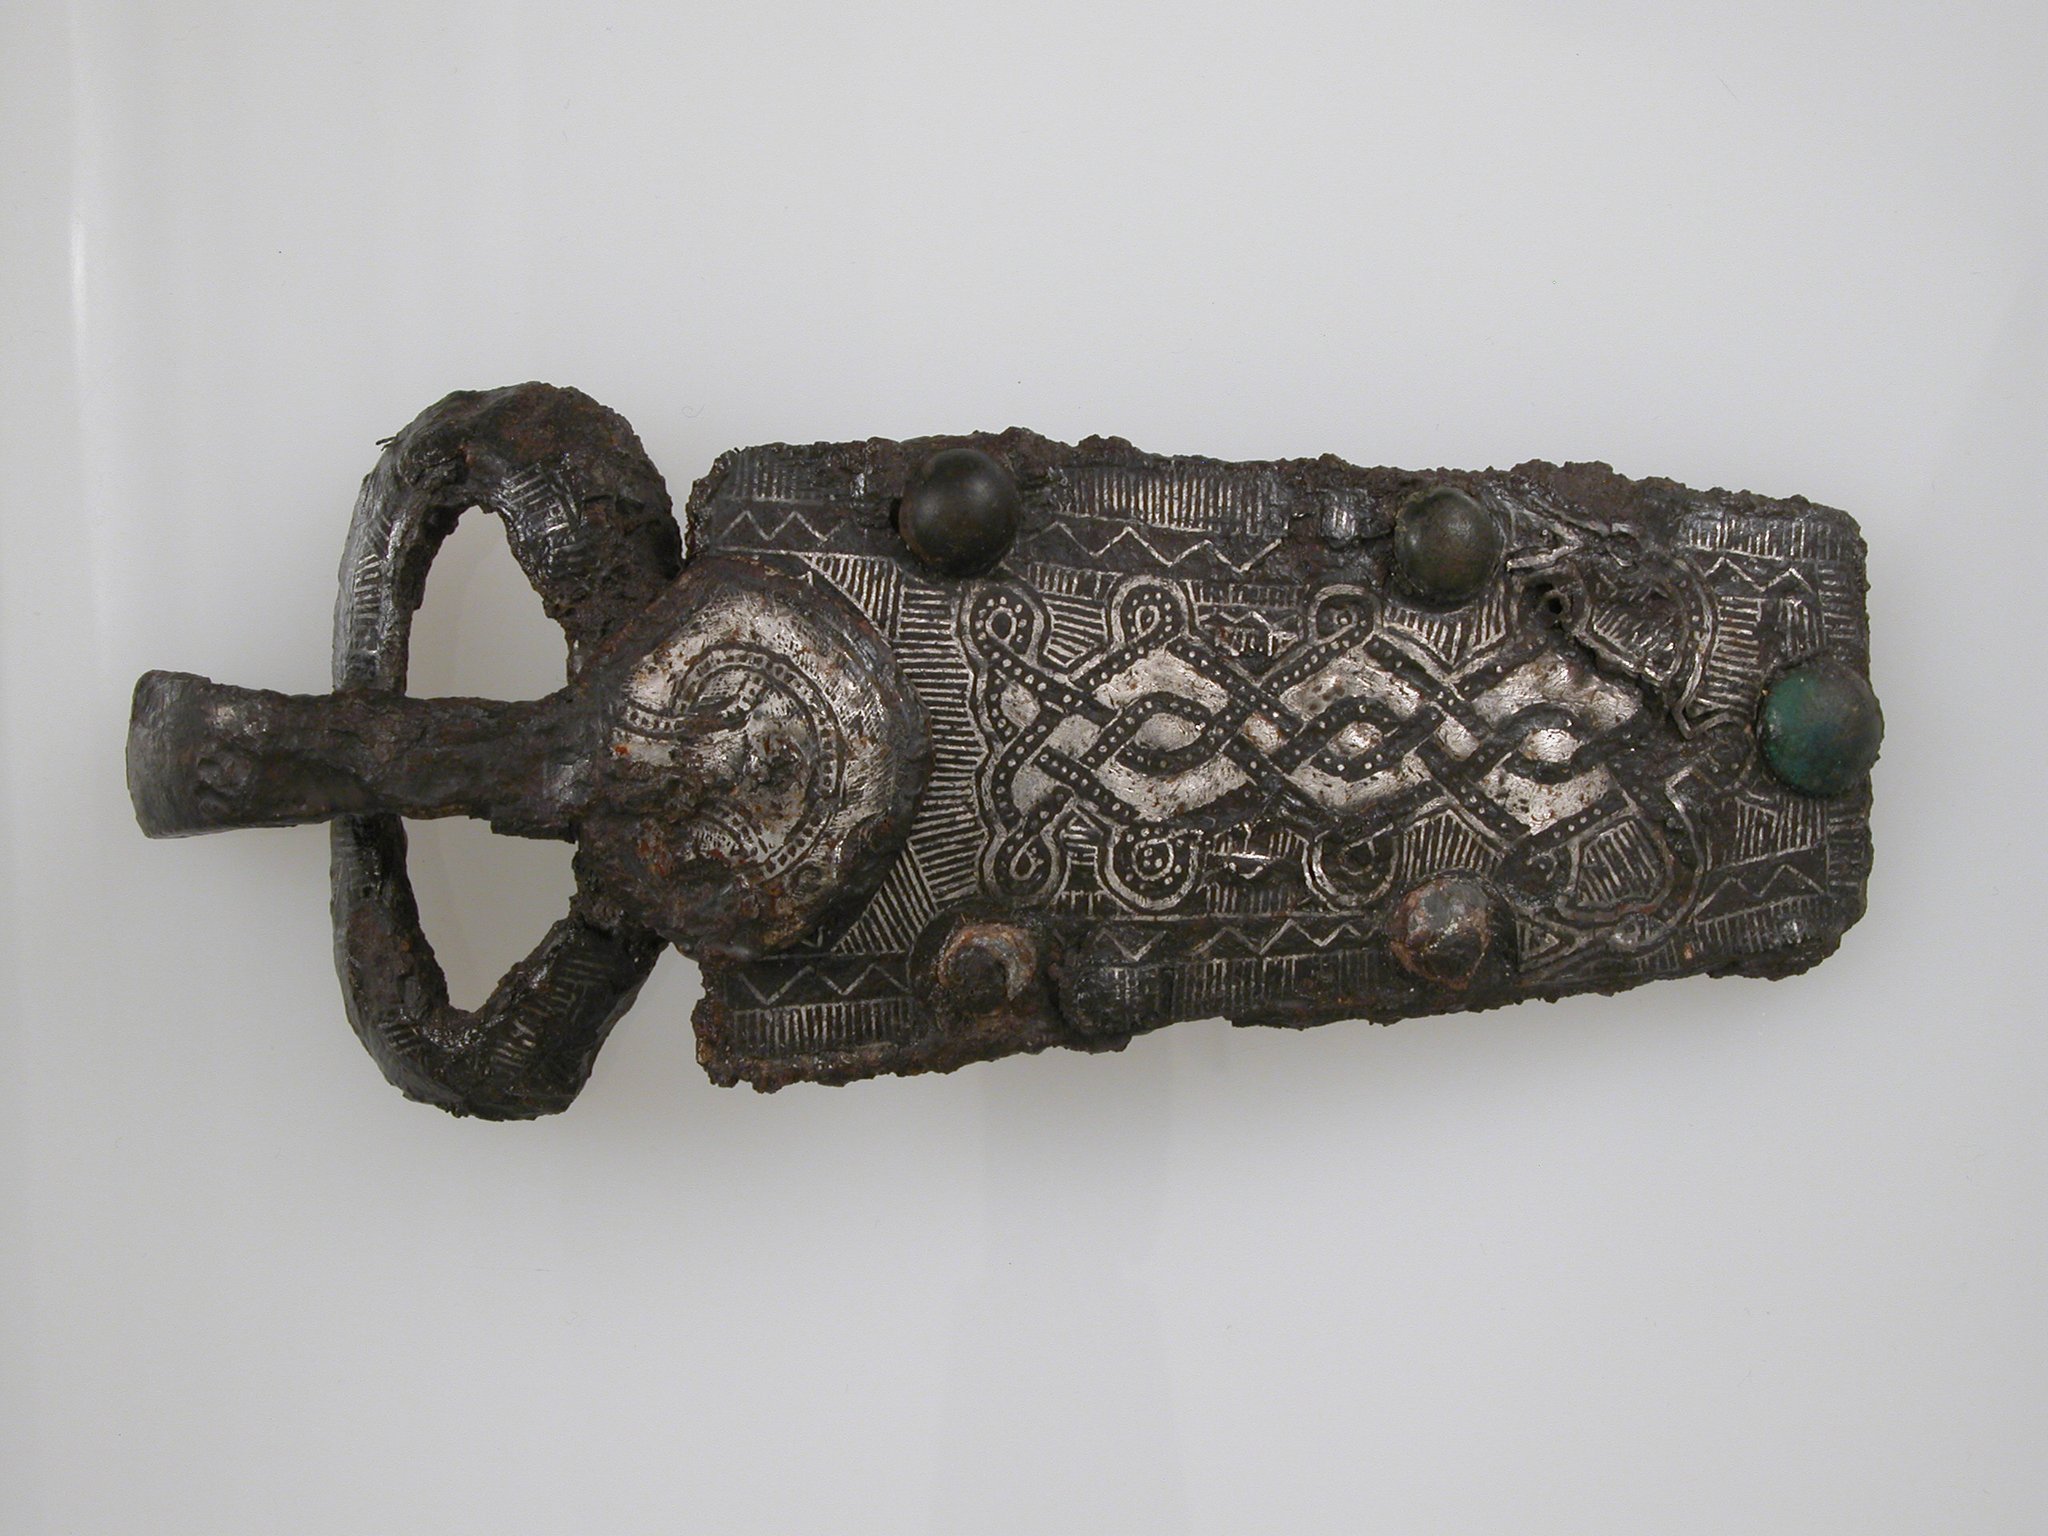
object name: belt buckle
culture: burgundian or frankish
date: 601-700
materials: bronze, iron, silver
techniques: inlay